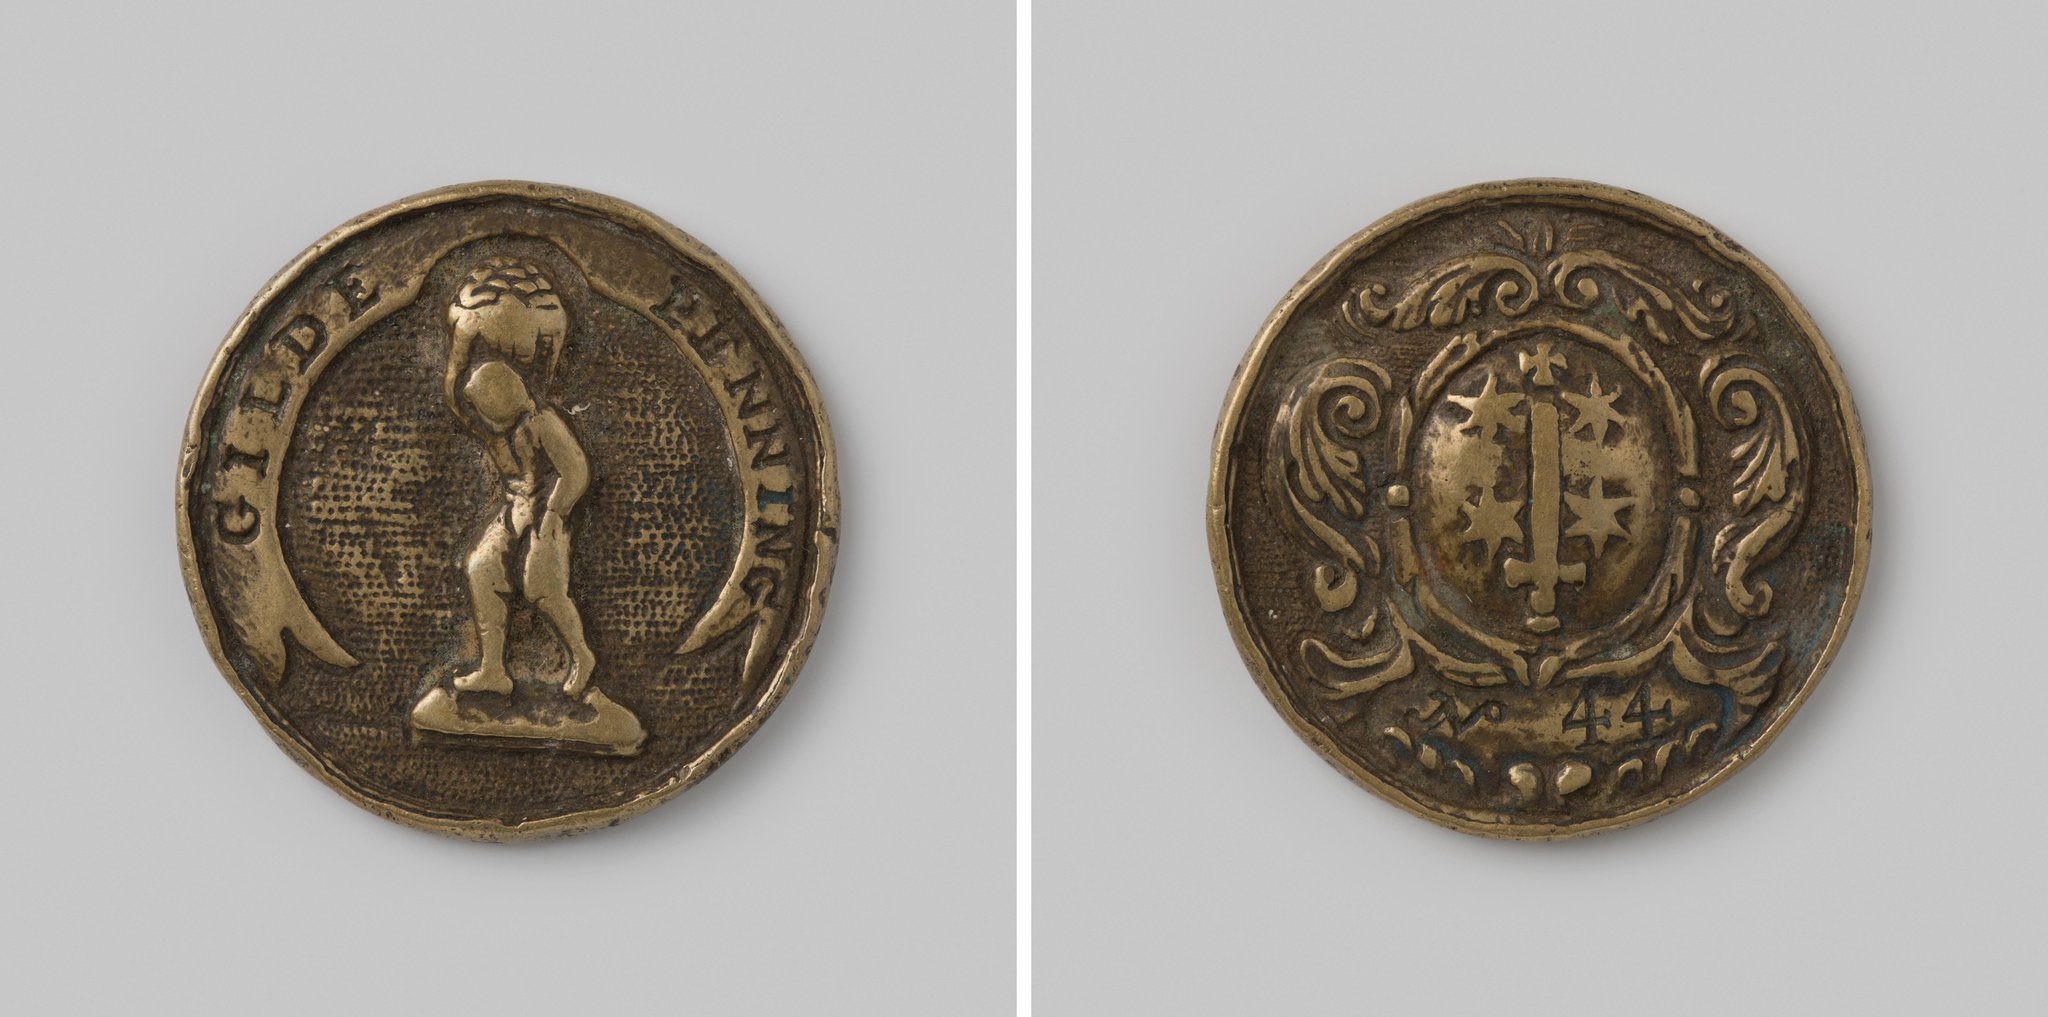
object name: history medal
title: Presentiepenning van het Turfdragersgilde te Haarlem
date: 1600-1800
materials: brass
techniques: casting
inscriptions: inscription: ‘No 44’, inscription: ‘GILDE - PENNING’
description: Gegoten messing penning, op de voorzijde een turfdrager en de tekst GILDE-PENNING op een banderol, op de keerzijde een versierd ovaal wapenschild van Haarlem en het cijfer 44